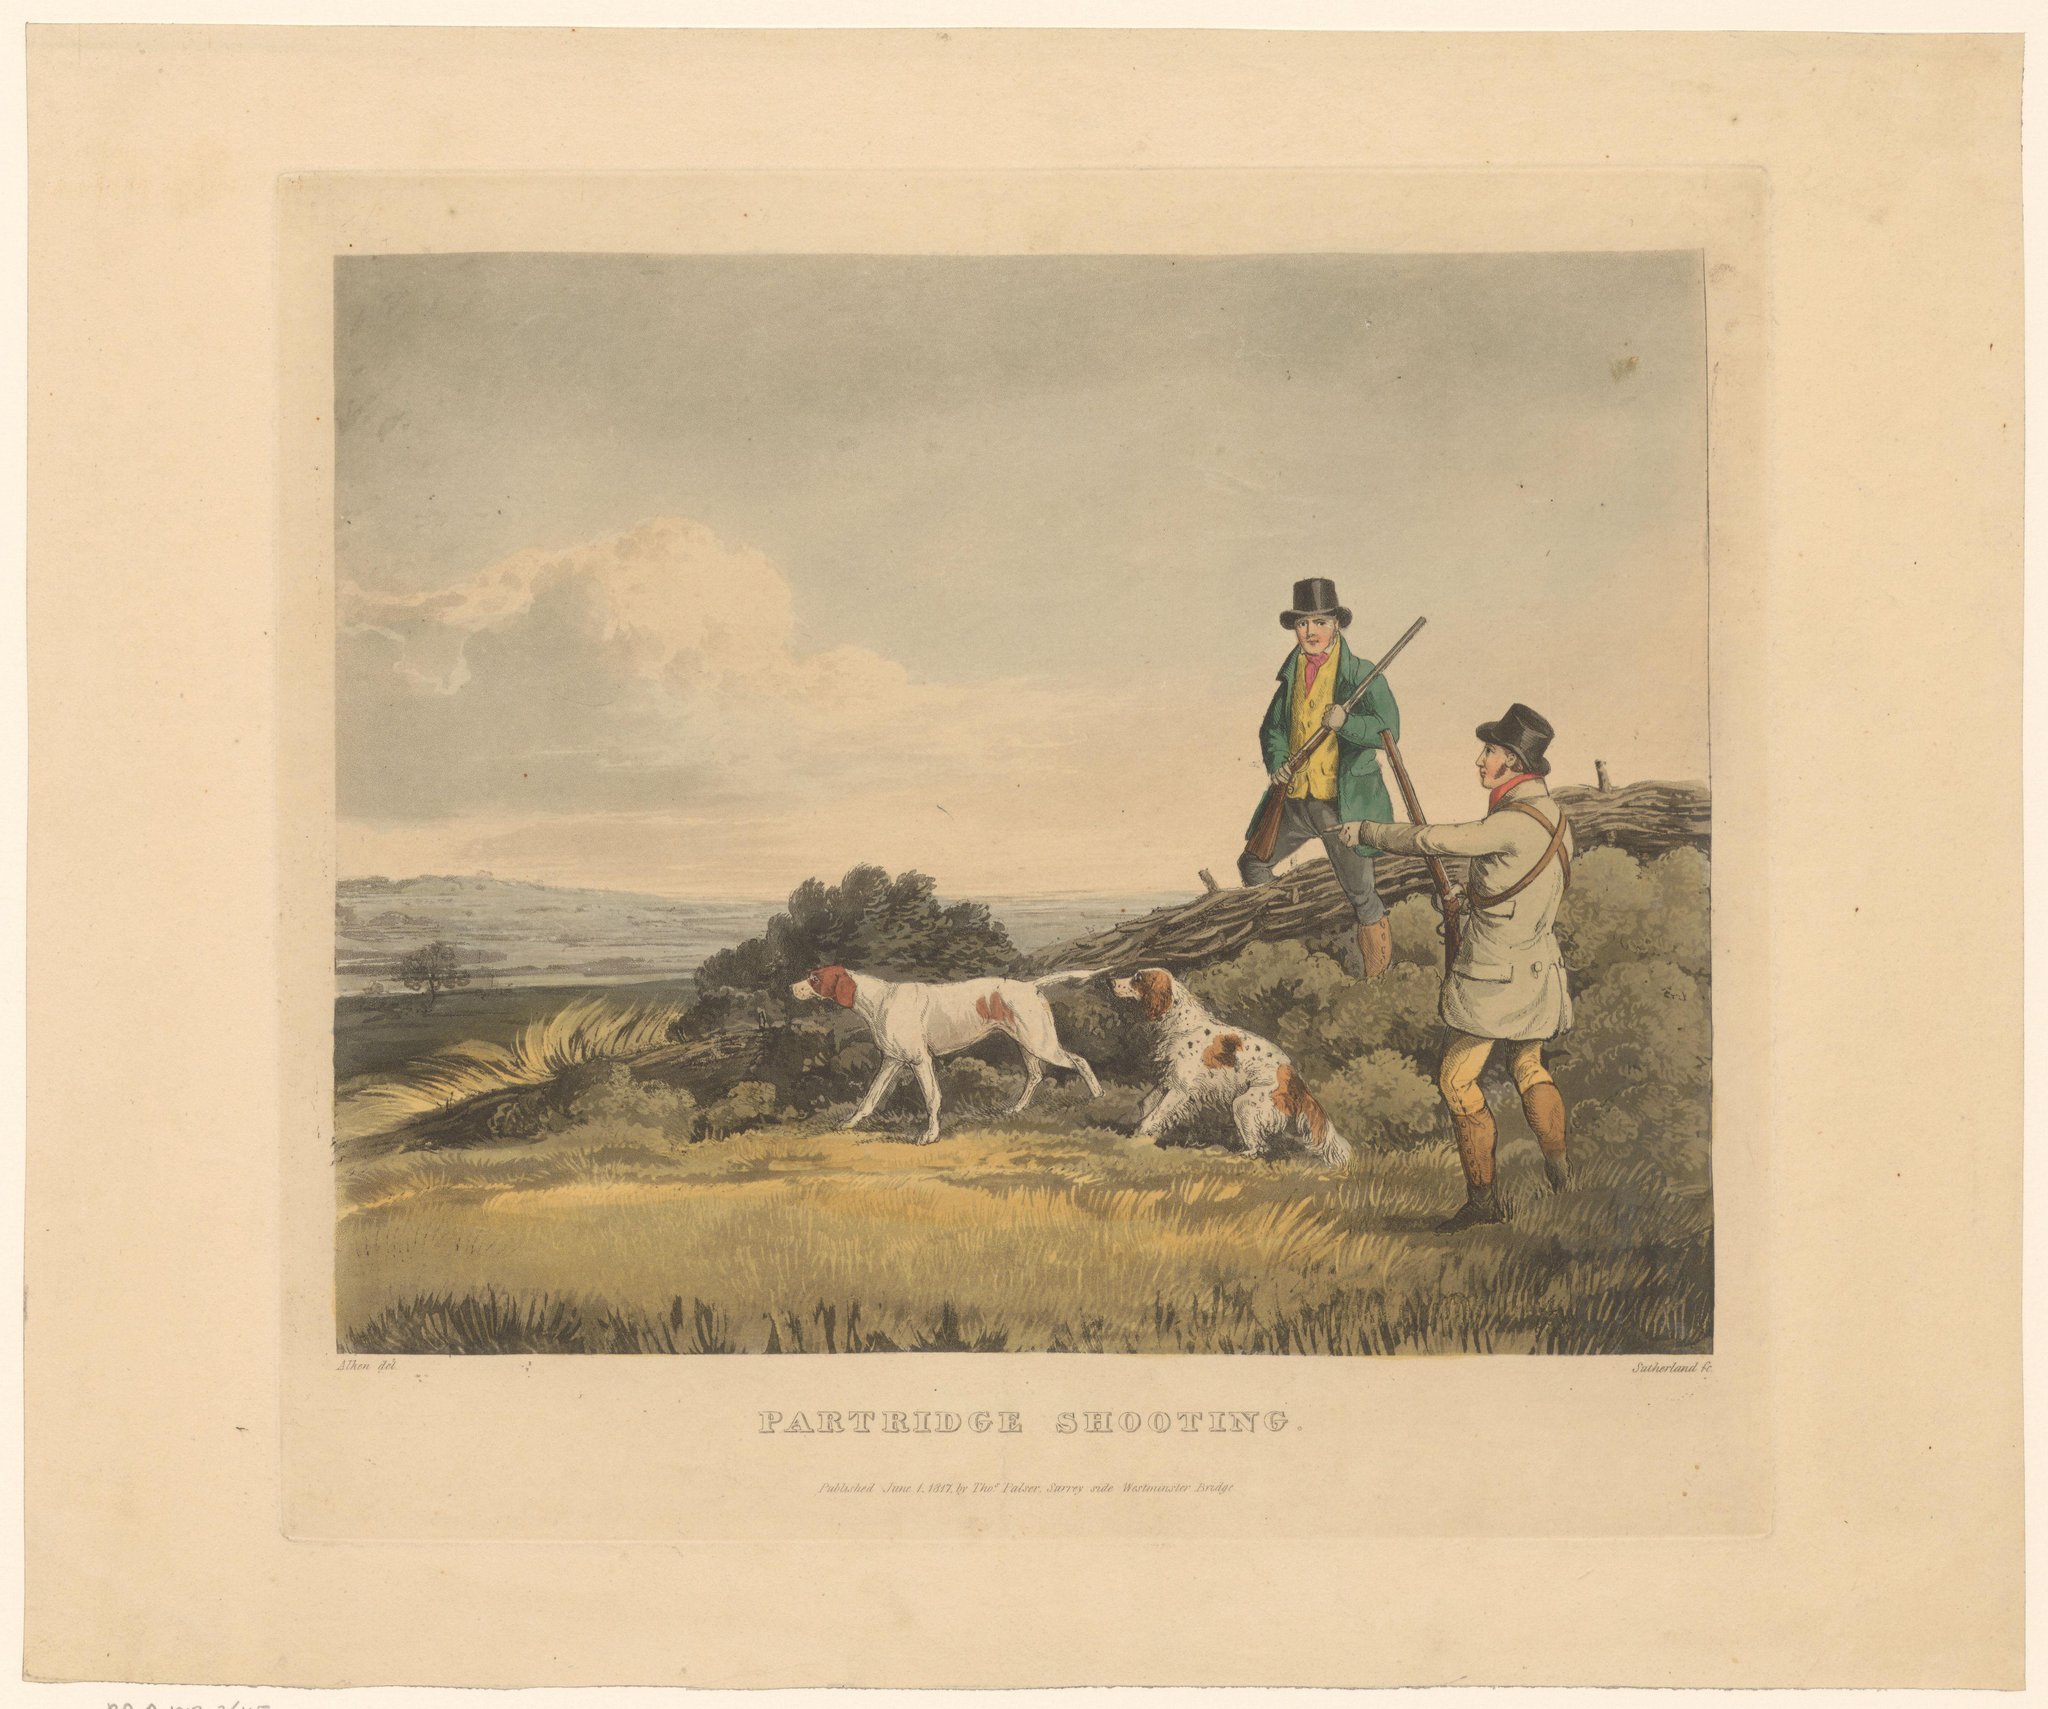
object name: print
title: Shooting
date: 1806-1817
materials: paper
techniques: etching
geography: london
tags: walker and runner birds: partridge, bird hunting, dog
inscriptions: collector's mark: Lugt 2233